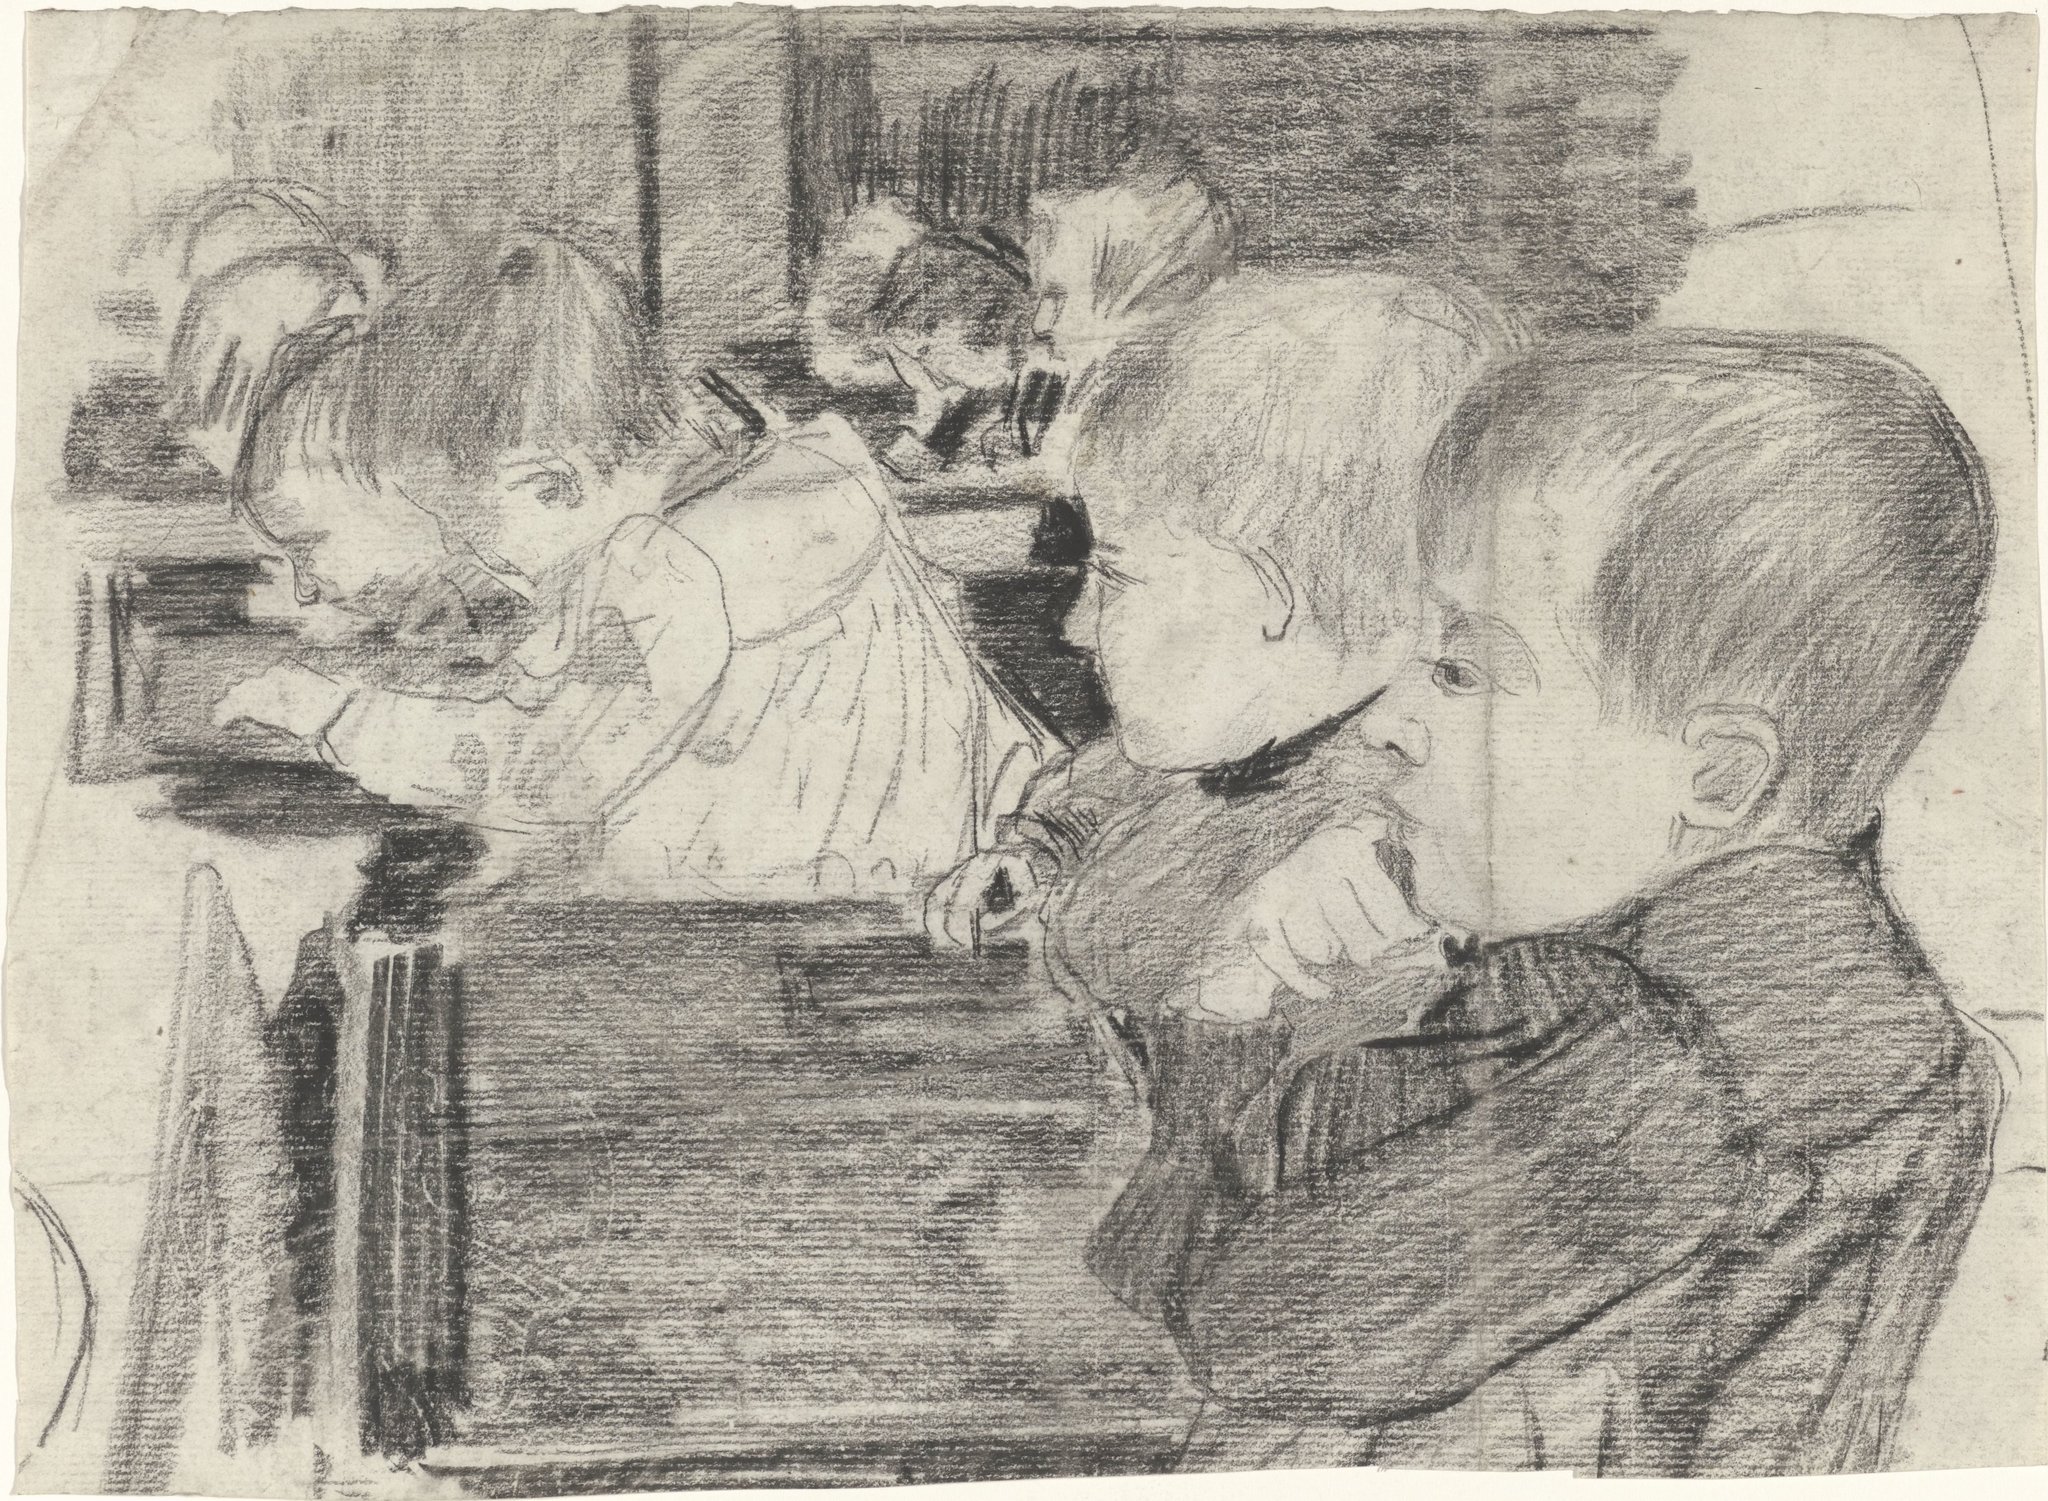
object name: drawing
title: Schoolklas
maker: carel adolph lion cachet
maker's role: draughtsman, print maker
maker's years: 1864-1945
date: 1874-1945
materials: chalk, paper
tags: elementary school; class, form